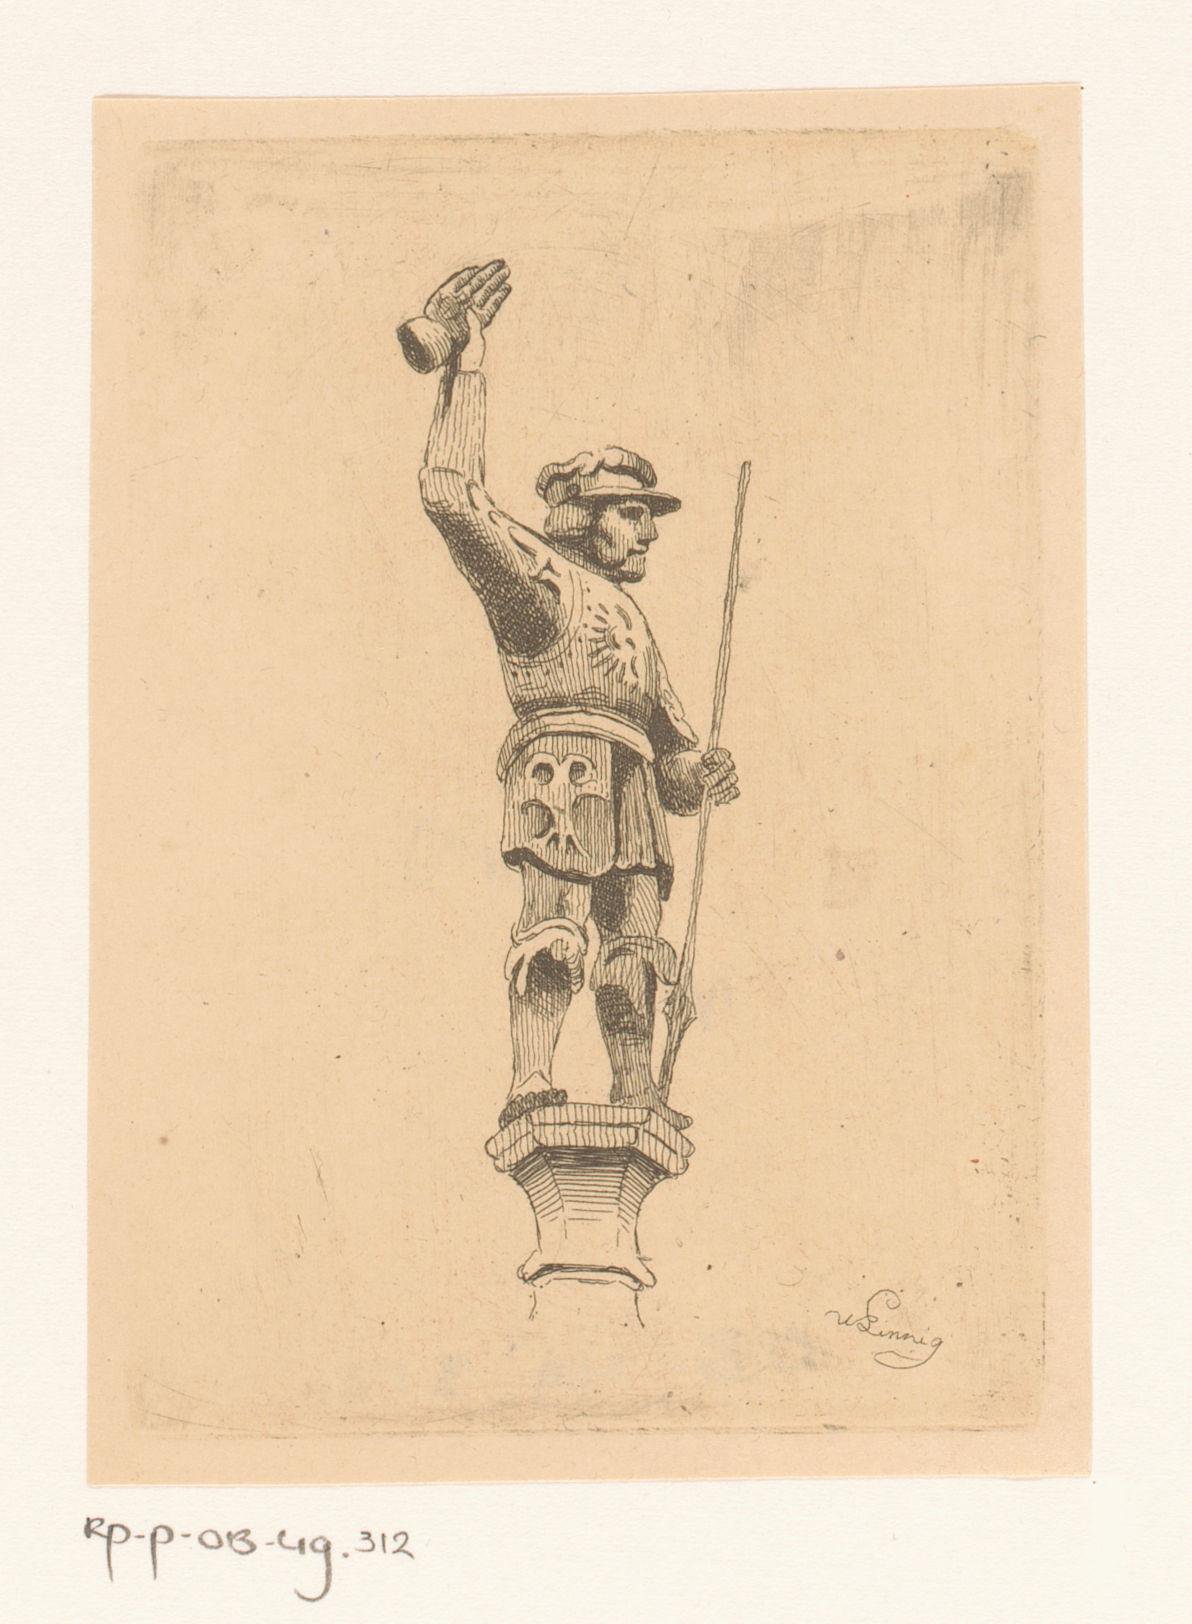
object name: print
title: Oude man met een stok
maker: willem linnig (i)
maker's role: print maker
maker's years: 1819-1885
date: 1850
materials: paper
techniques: etching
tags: walking-stick, staff, old man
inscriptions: collector's mark: Lugt 2228, collector's mark: Lugt 1485